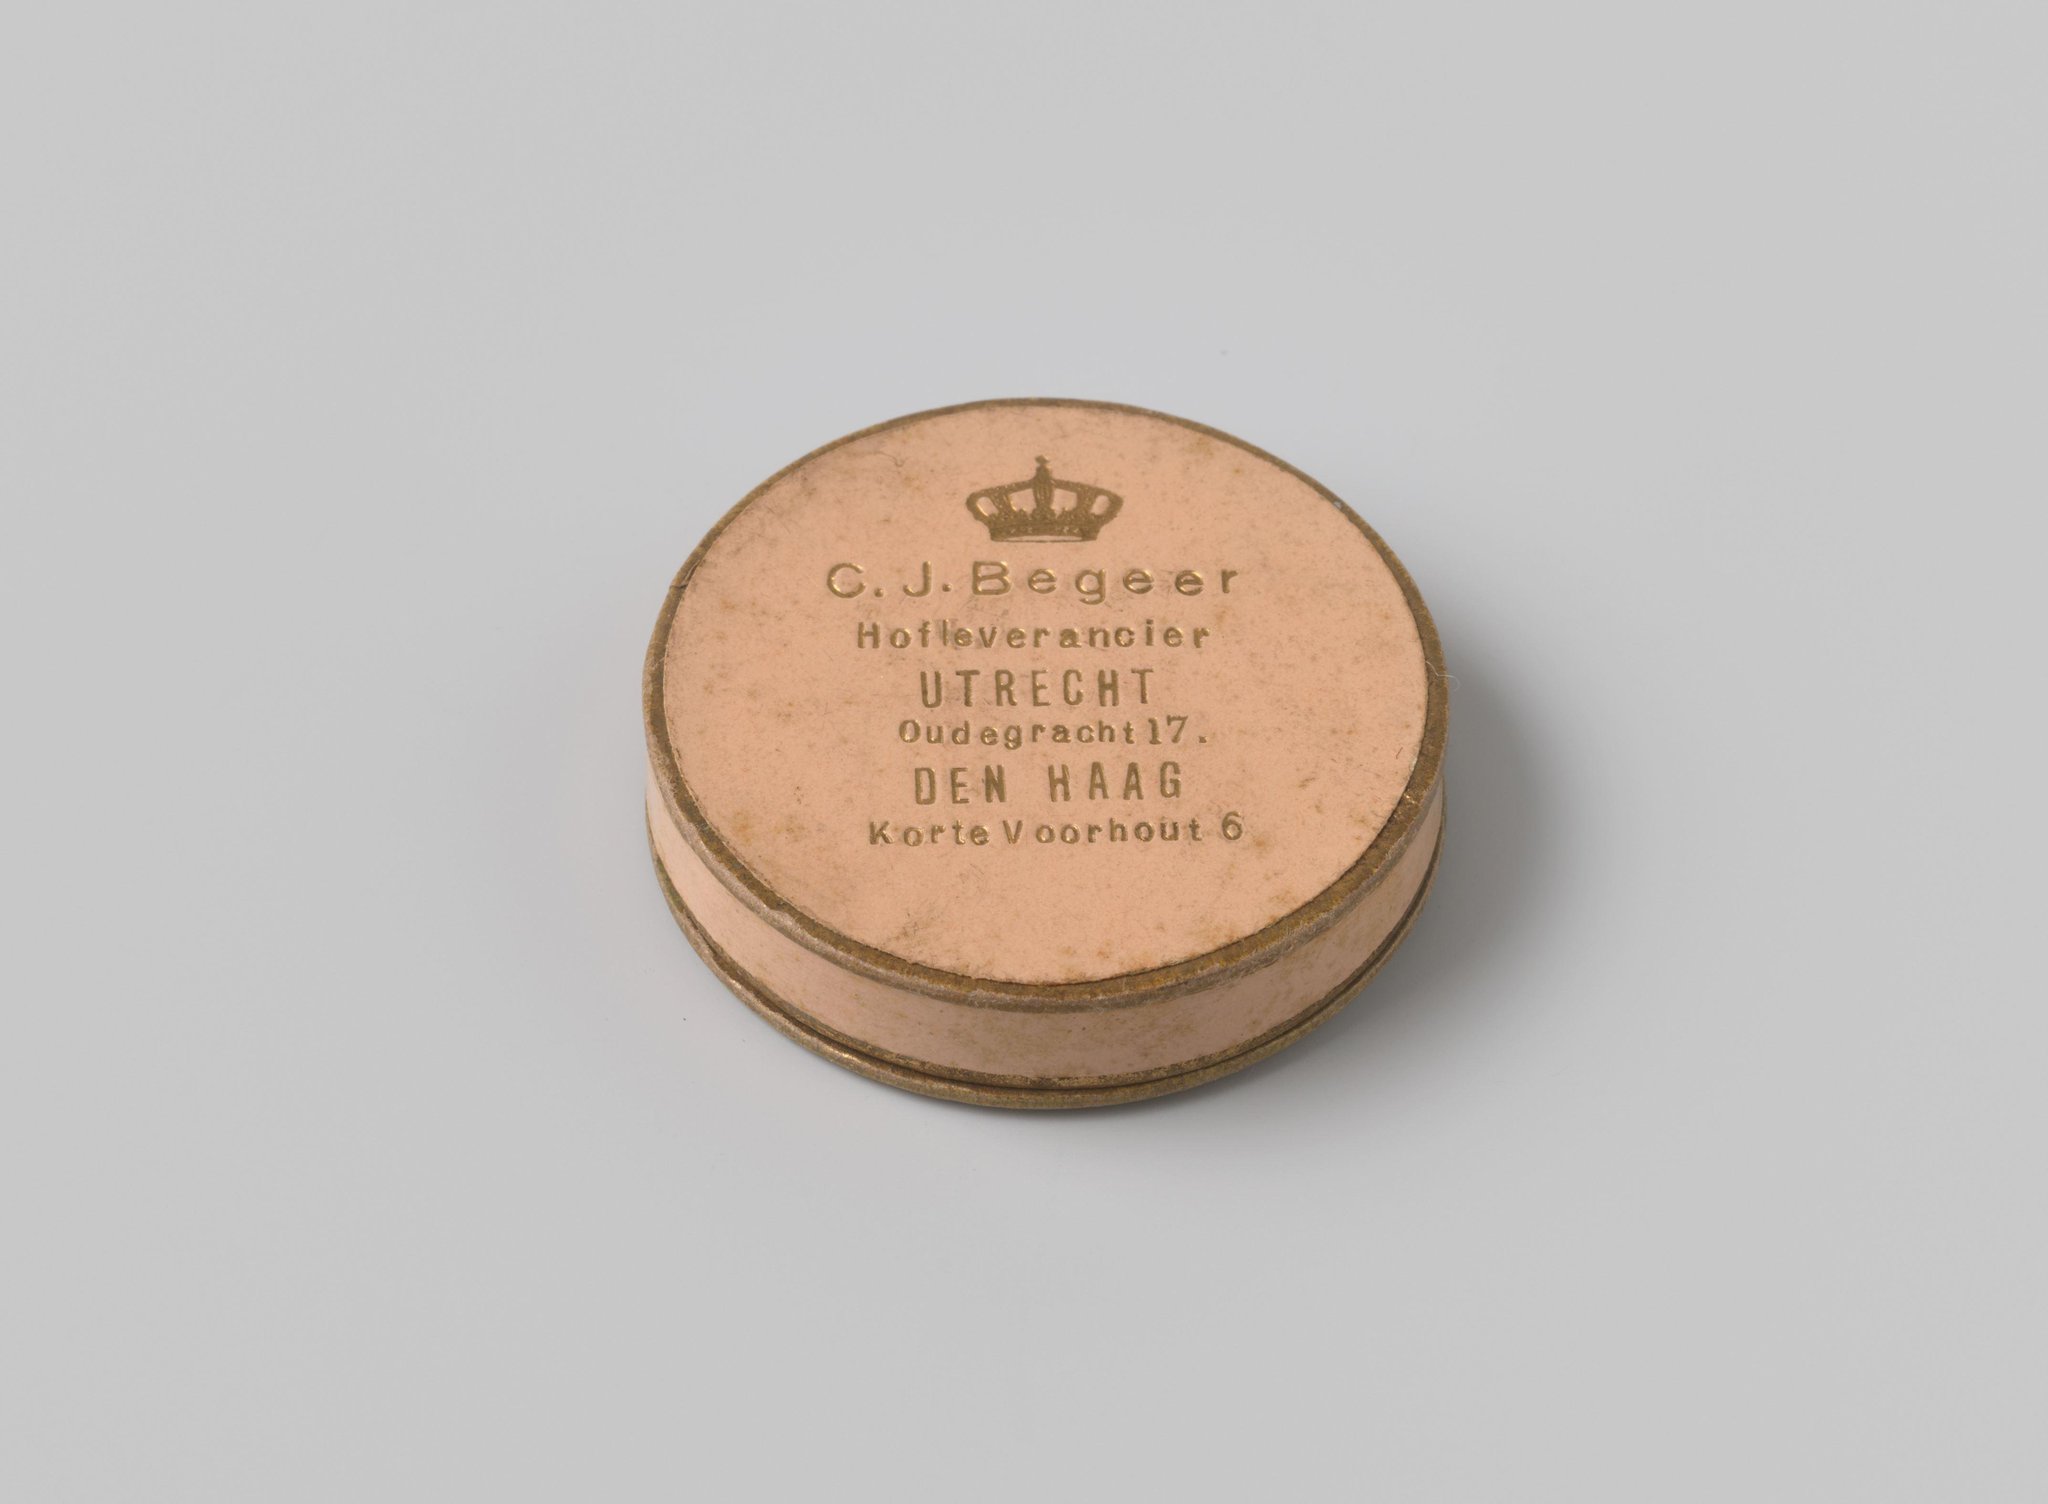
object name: box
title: Doos horend bij een zilveren penning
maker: m. vreugde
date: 1914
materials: velvet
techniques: striking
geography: utrecht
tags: amsterdam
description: Rond kartonnen doosje. Op de deksel staat: C.J. Begeer Huisleverancier UTRECHT Oudegracht 17 Den Haag Korte Voorhout 6.